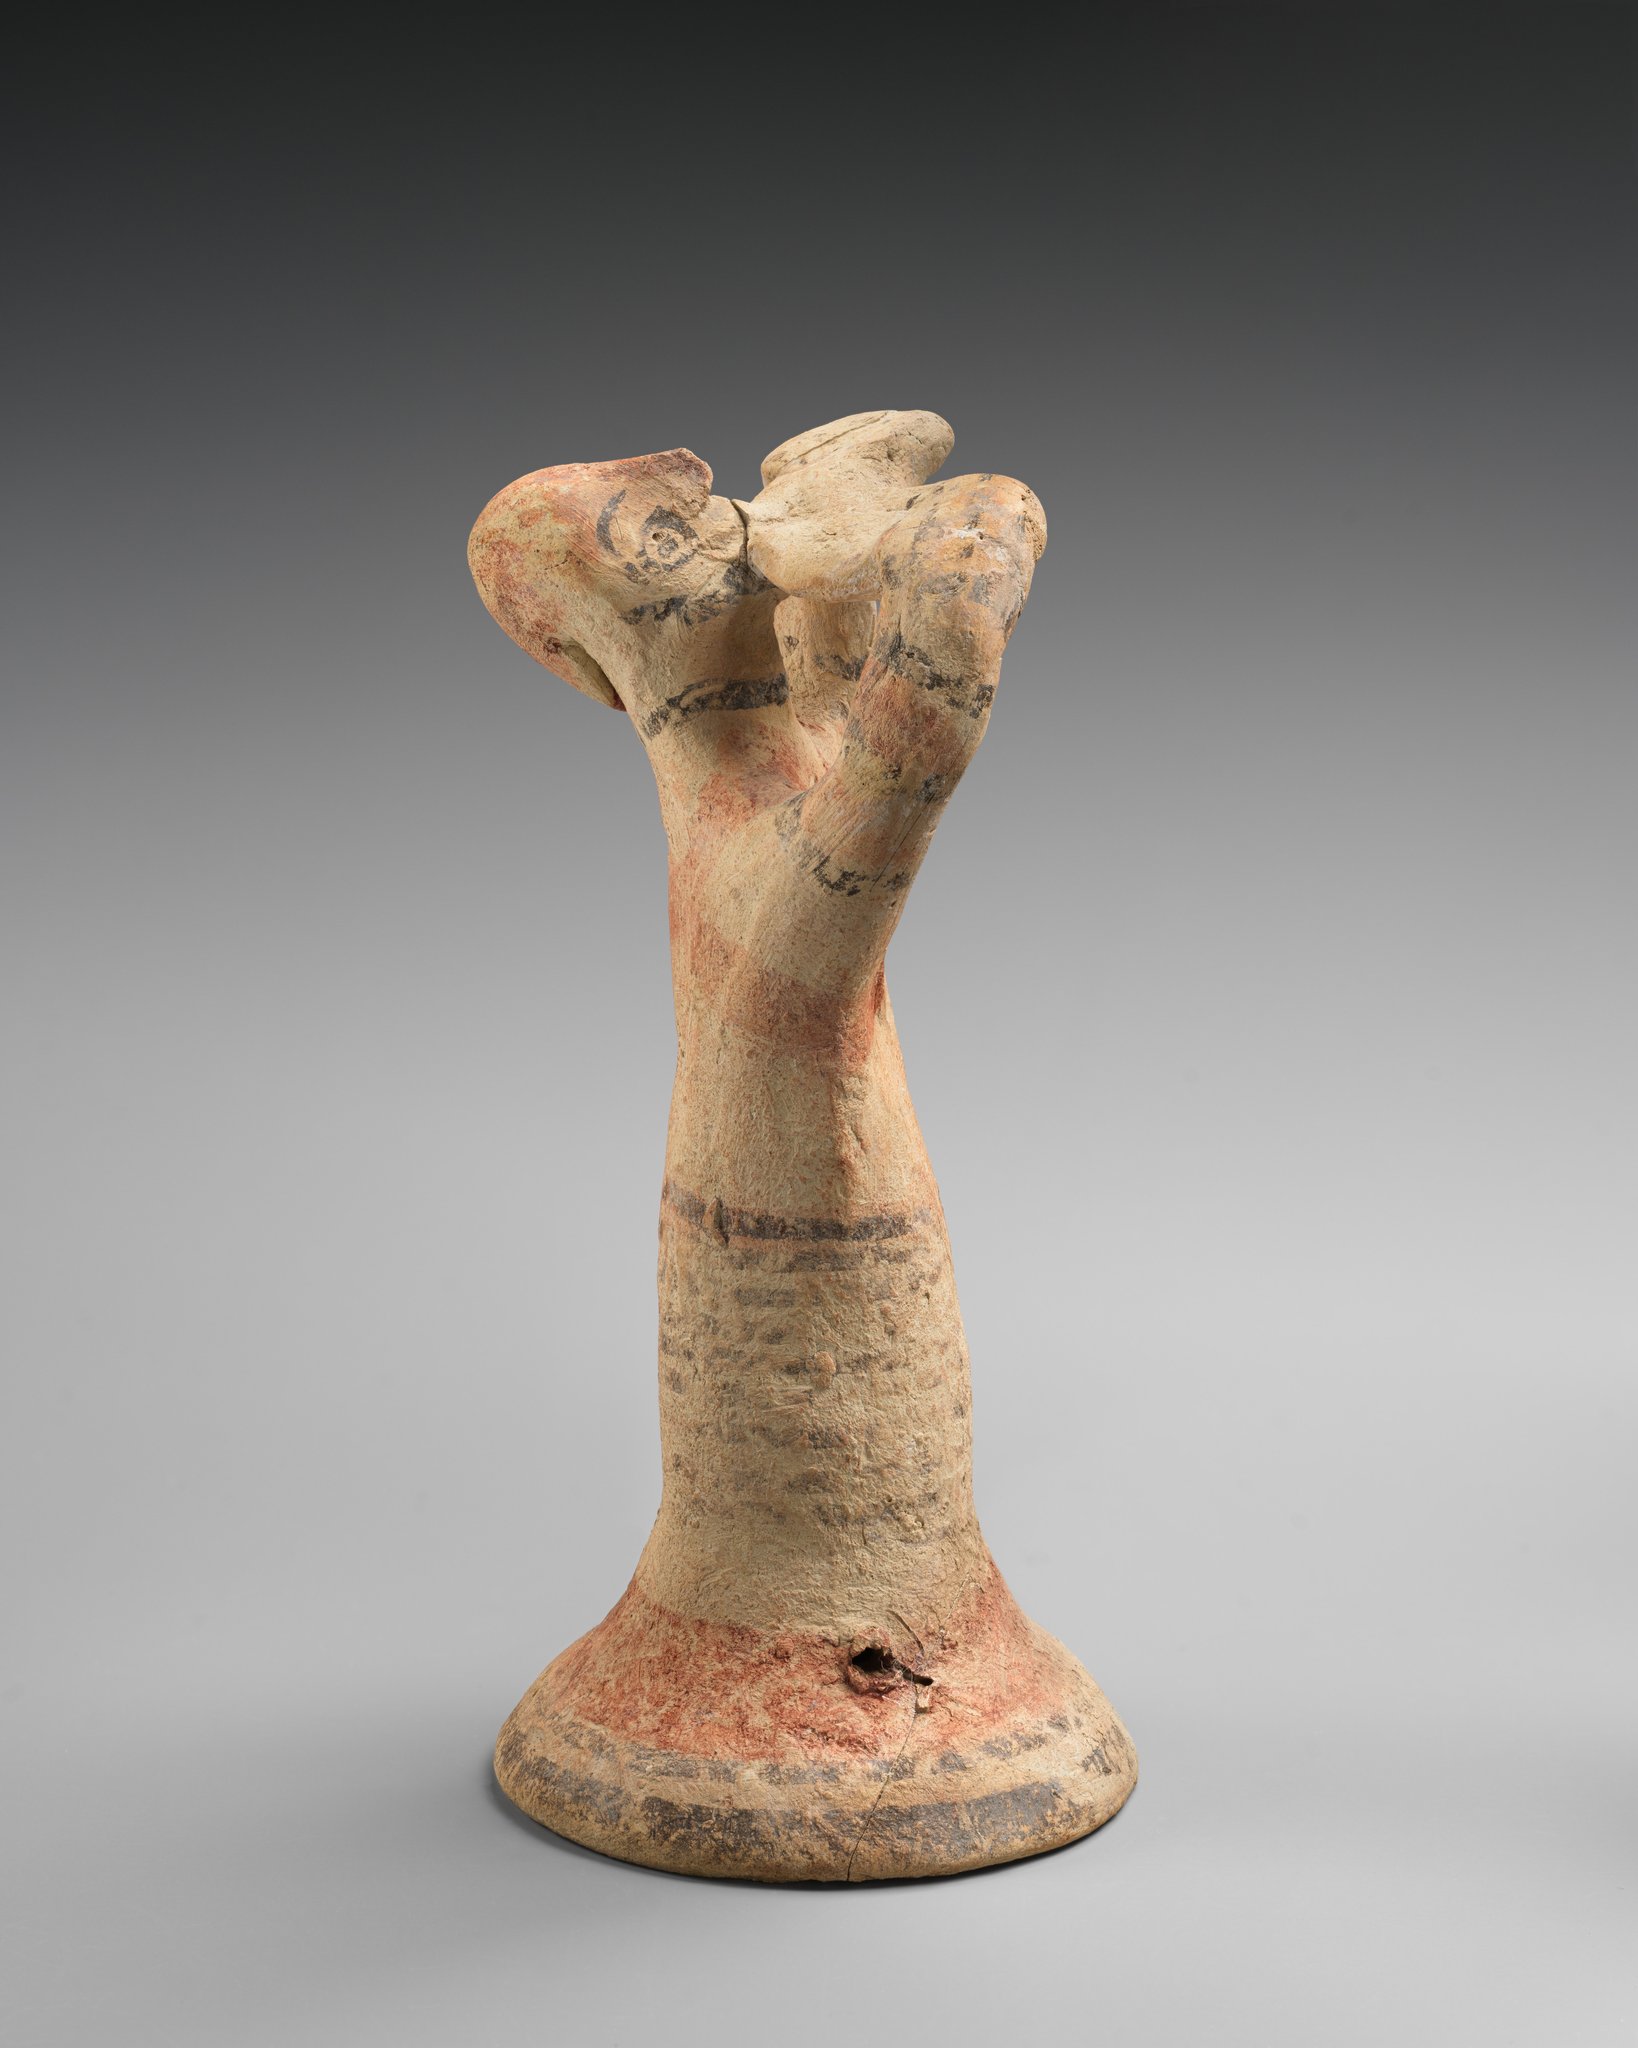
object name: statuette of a flute player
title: Terracotta statuette of a male flute-player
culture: cypriot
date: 750-600 BCE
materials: terracotta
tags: men,flutes,musicians